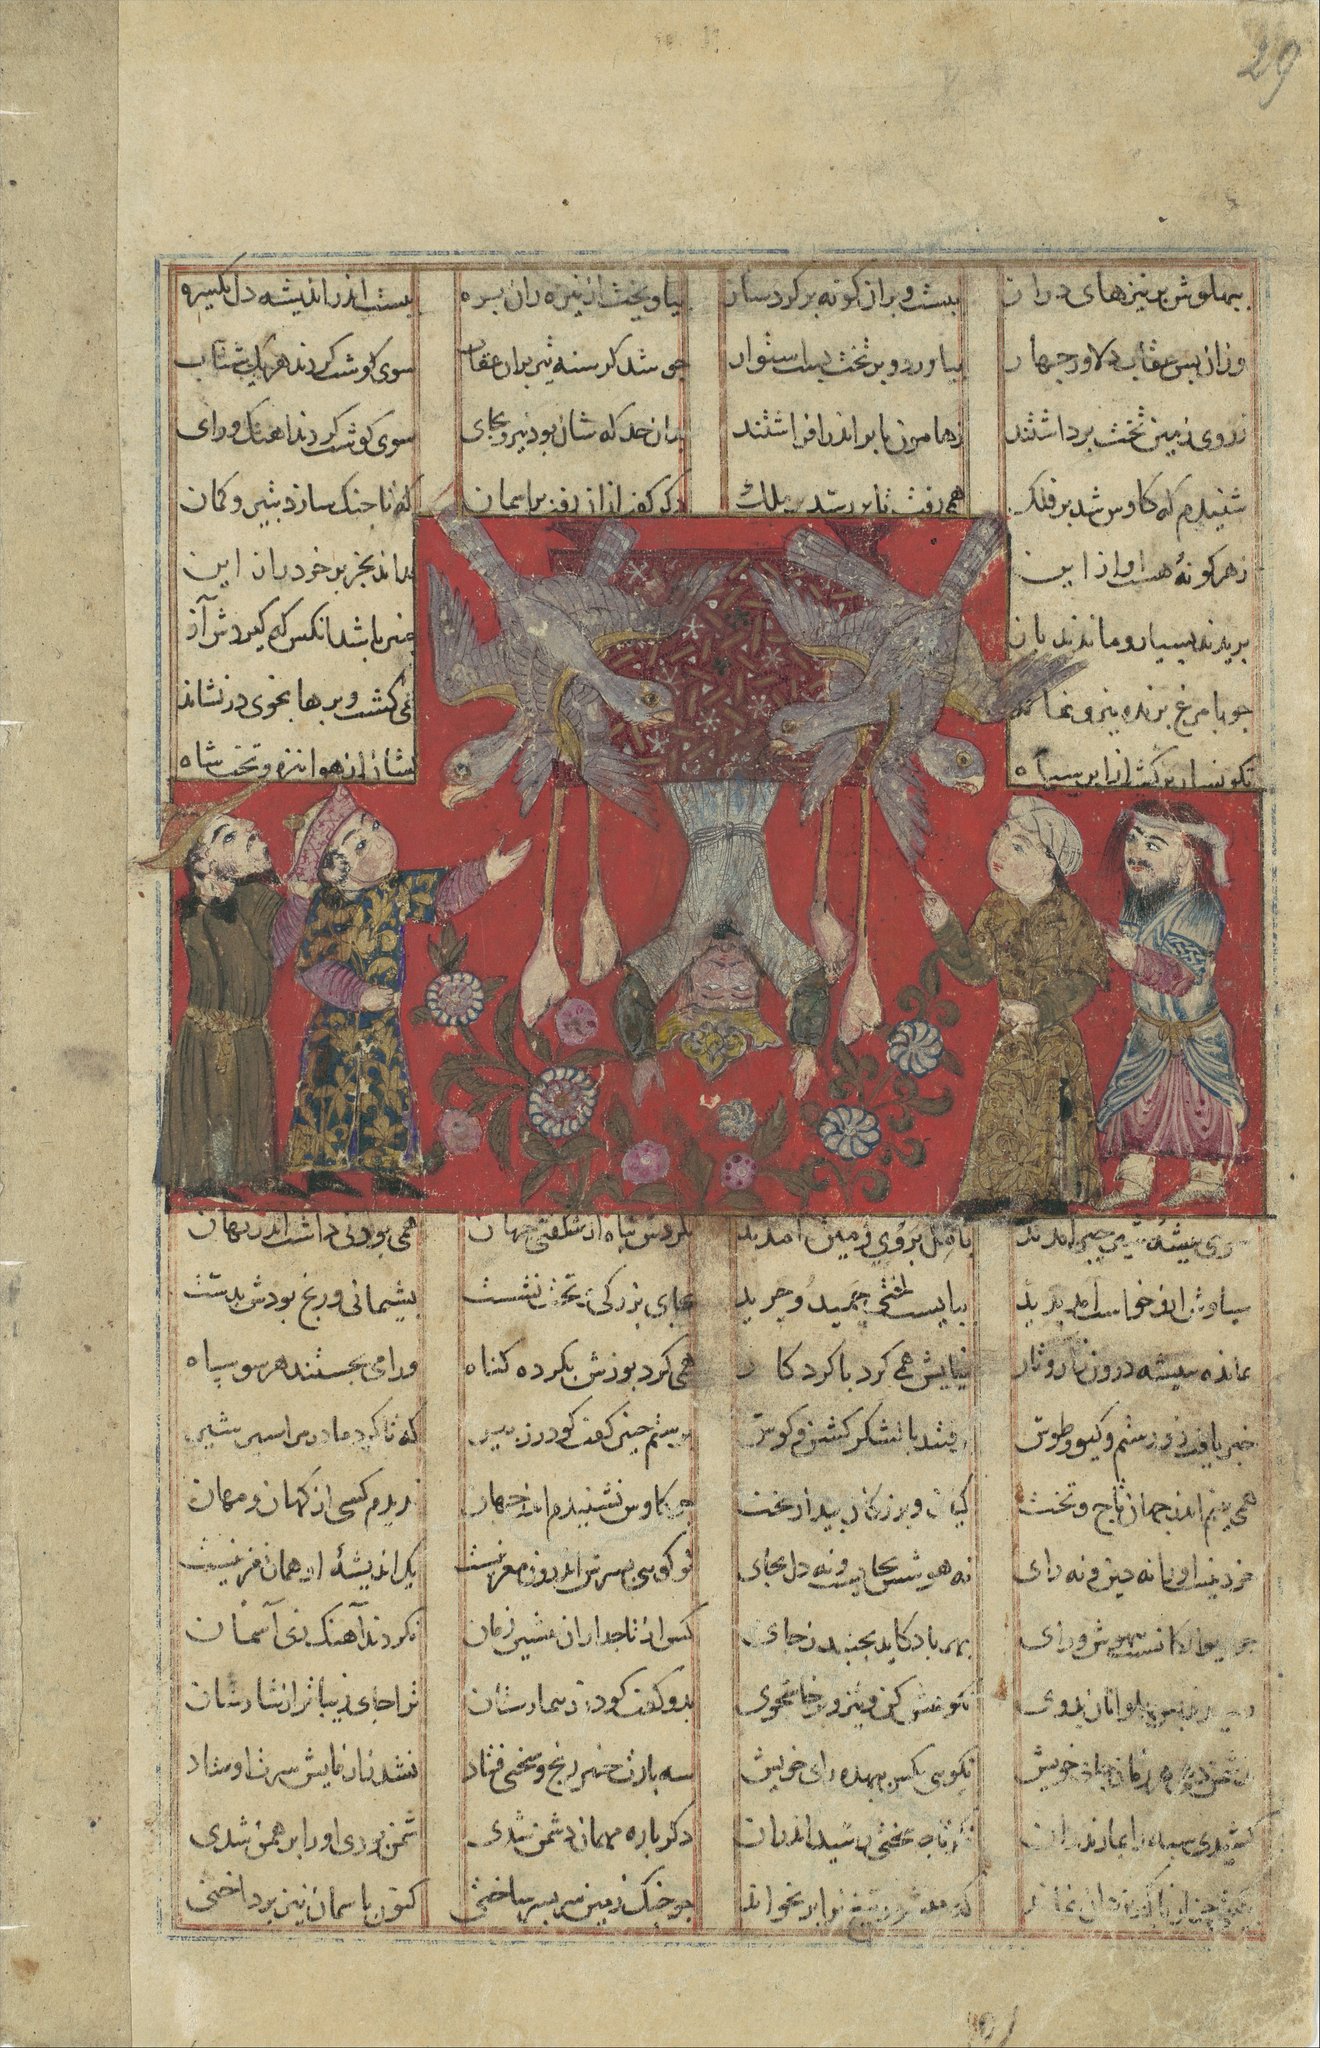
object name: folio from an illustrated manuscript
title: "Kai Kavus Falls from the Sky", Folio from a Shahnama (Book of Kings) of Firdausi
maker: abu'l qasim firdausi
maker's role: author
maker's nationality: iranian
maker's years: 935-1020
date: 1330-1340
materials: gold, ink, paper, silver, watercolor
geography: iran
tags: eagles,men